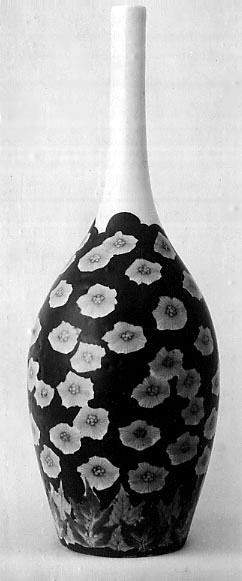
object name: bottle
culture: japanese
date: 1701-1800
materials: glaze, porcelain